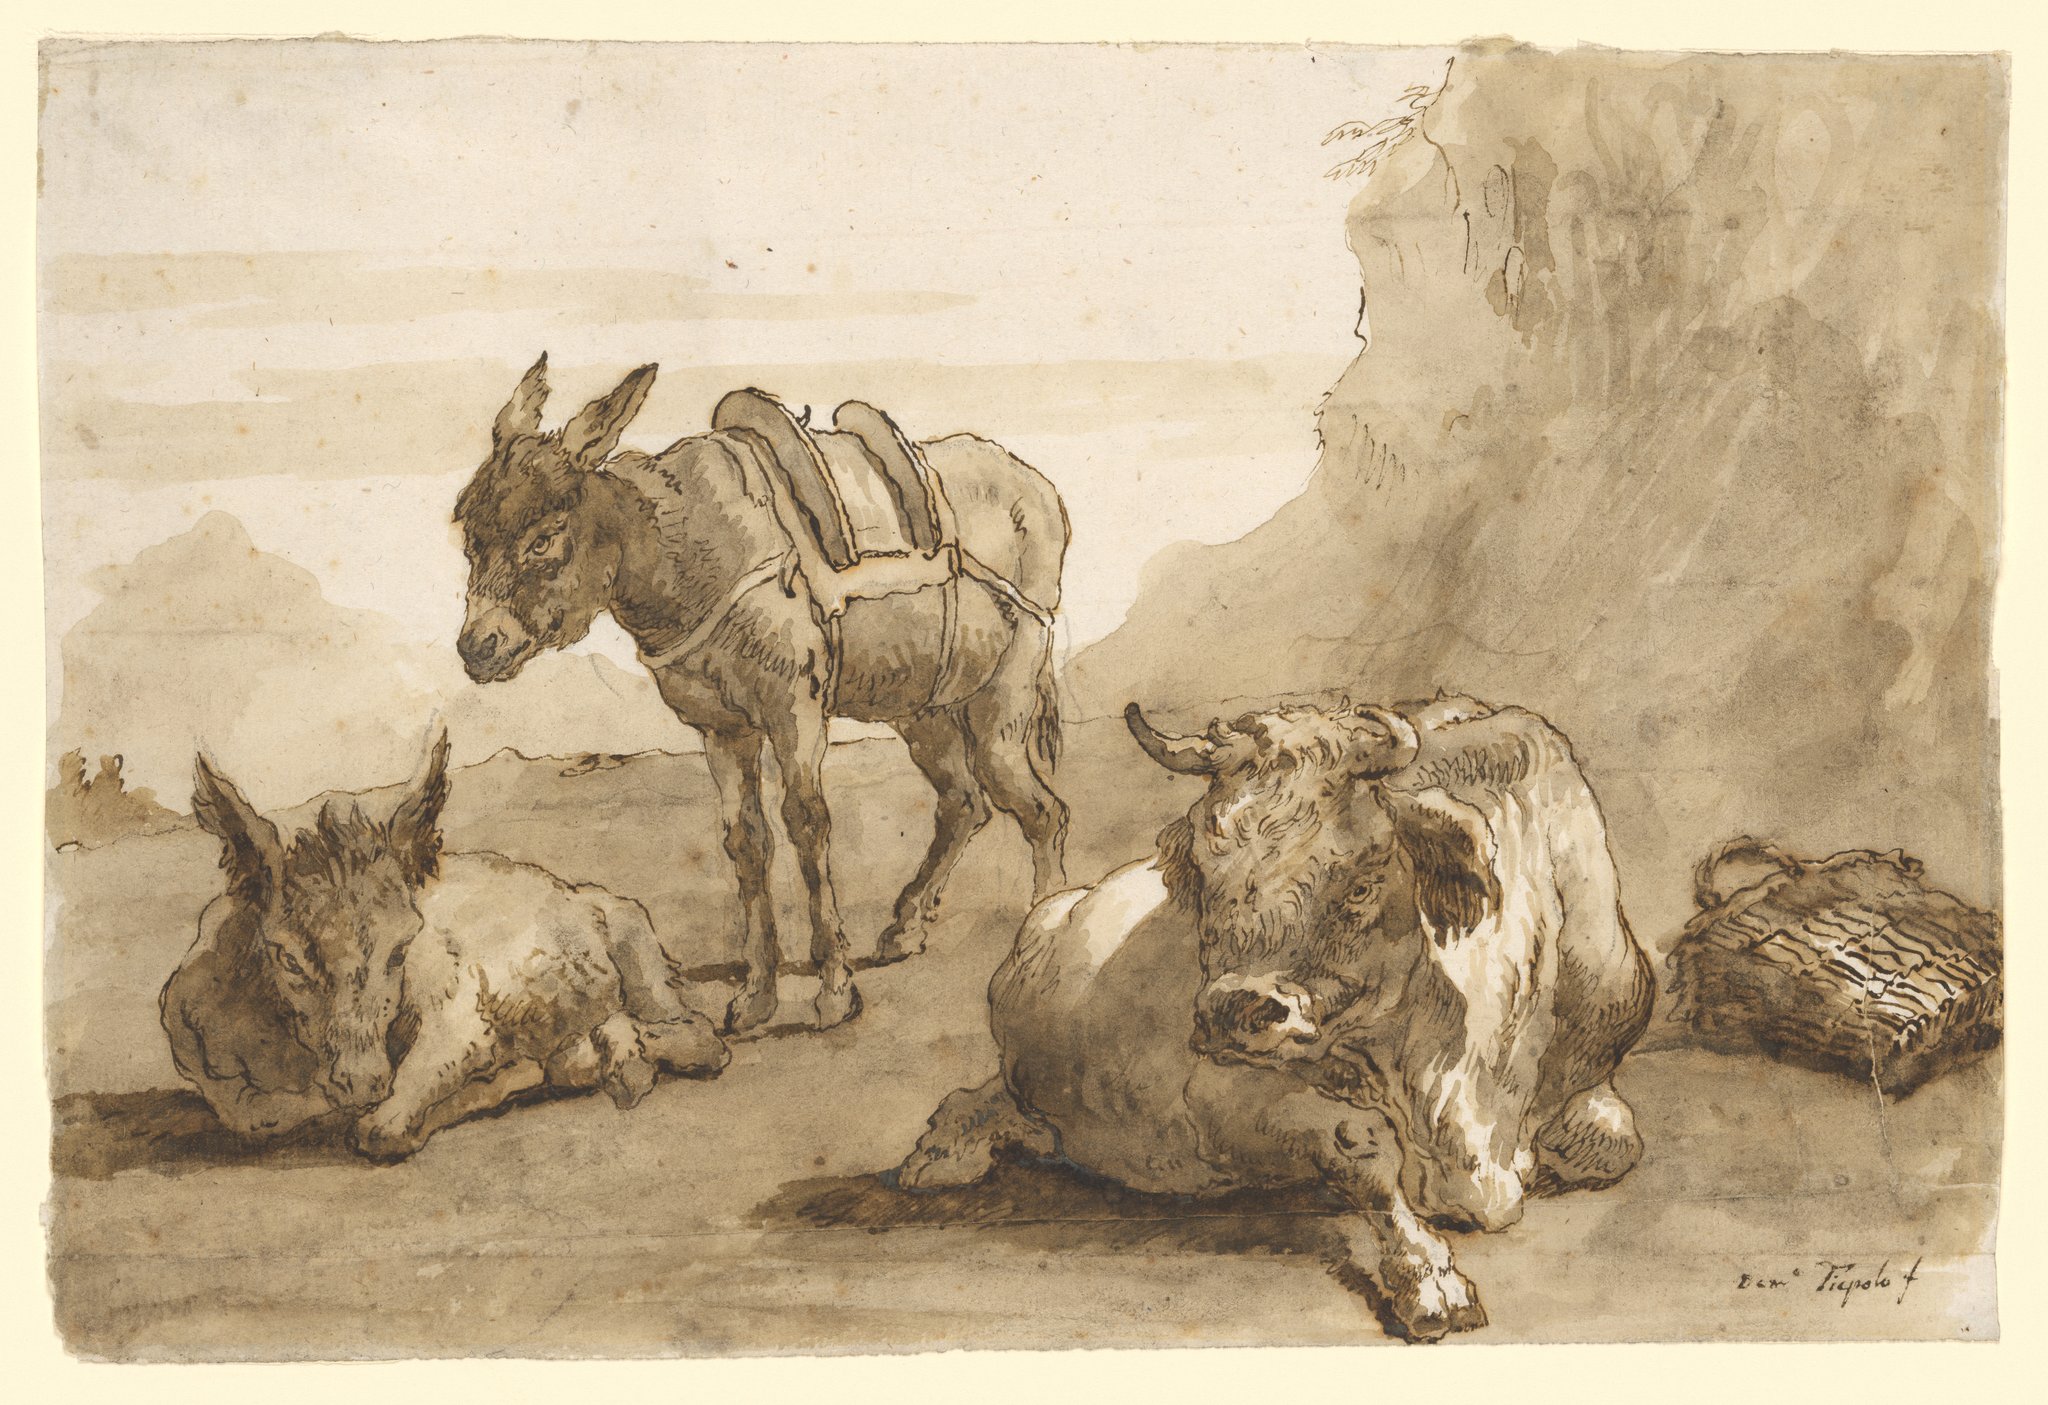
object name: drawing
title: A Bull Lying Down, and Two Donkeys, in a Landscape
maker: giovanni domenico tiepolo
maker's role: artist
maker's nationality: italian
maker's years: 1727-1804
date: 1760-1761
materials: chalk, ink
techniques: pen, wash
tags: bulls,donkeys